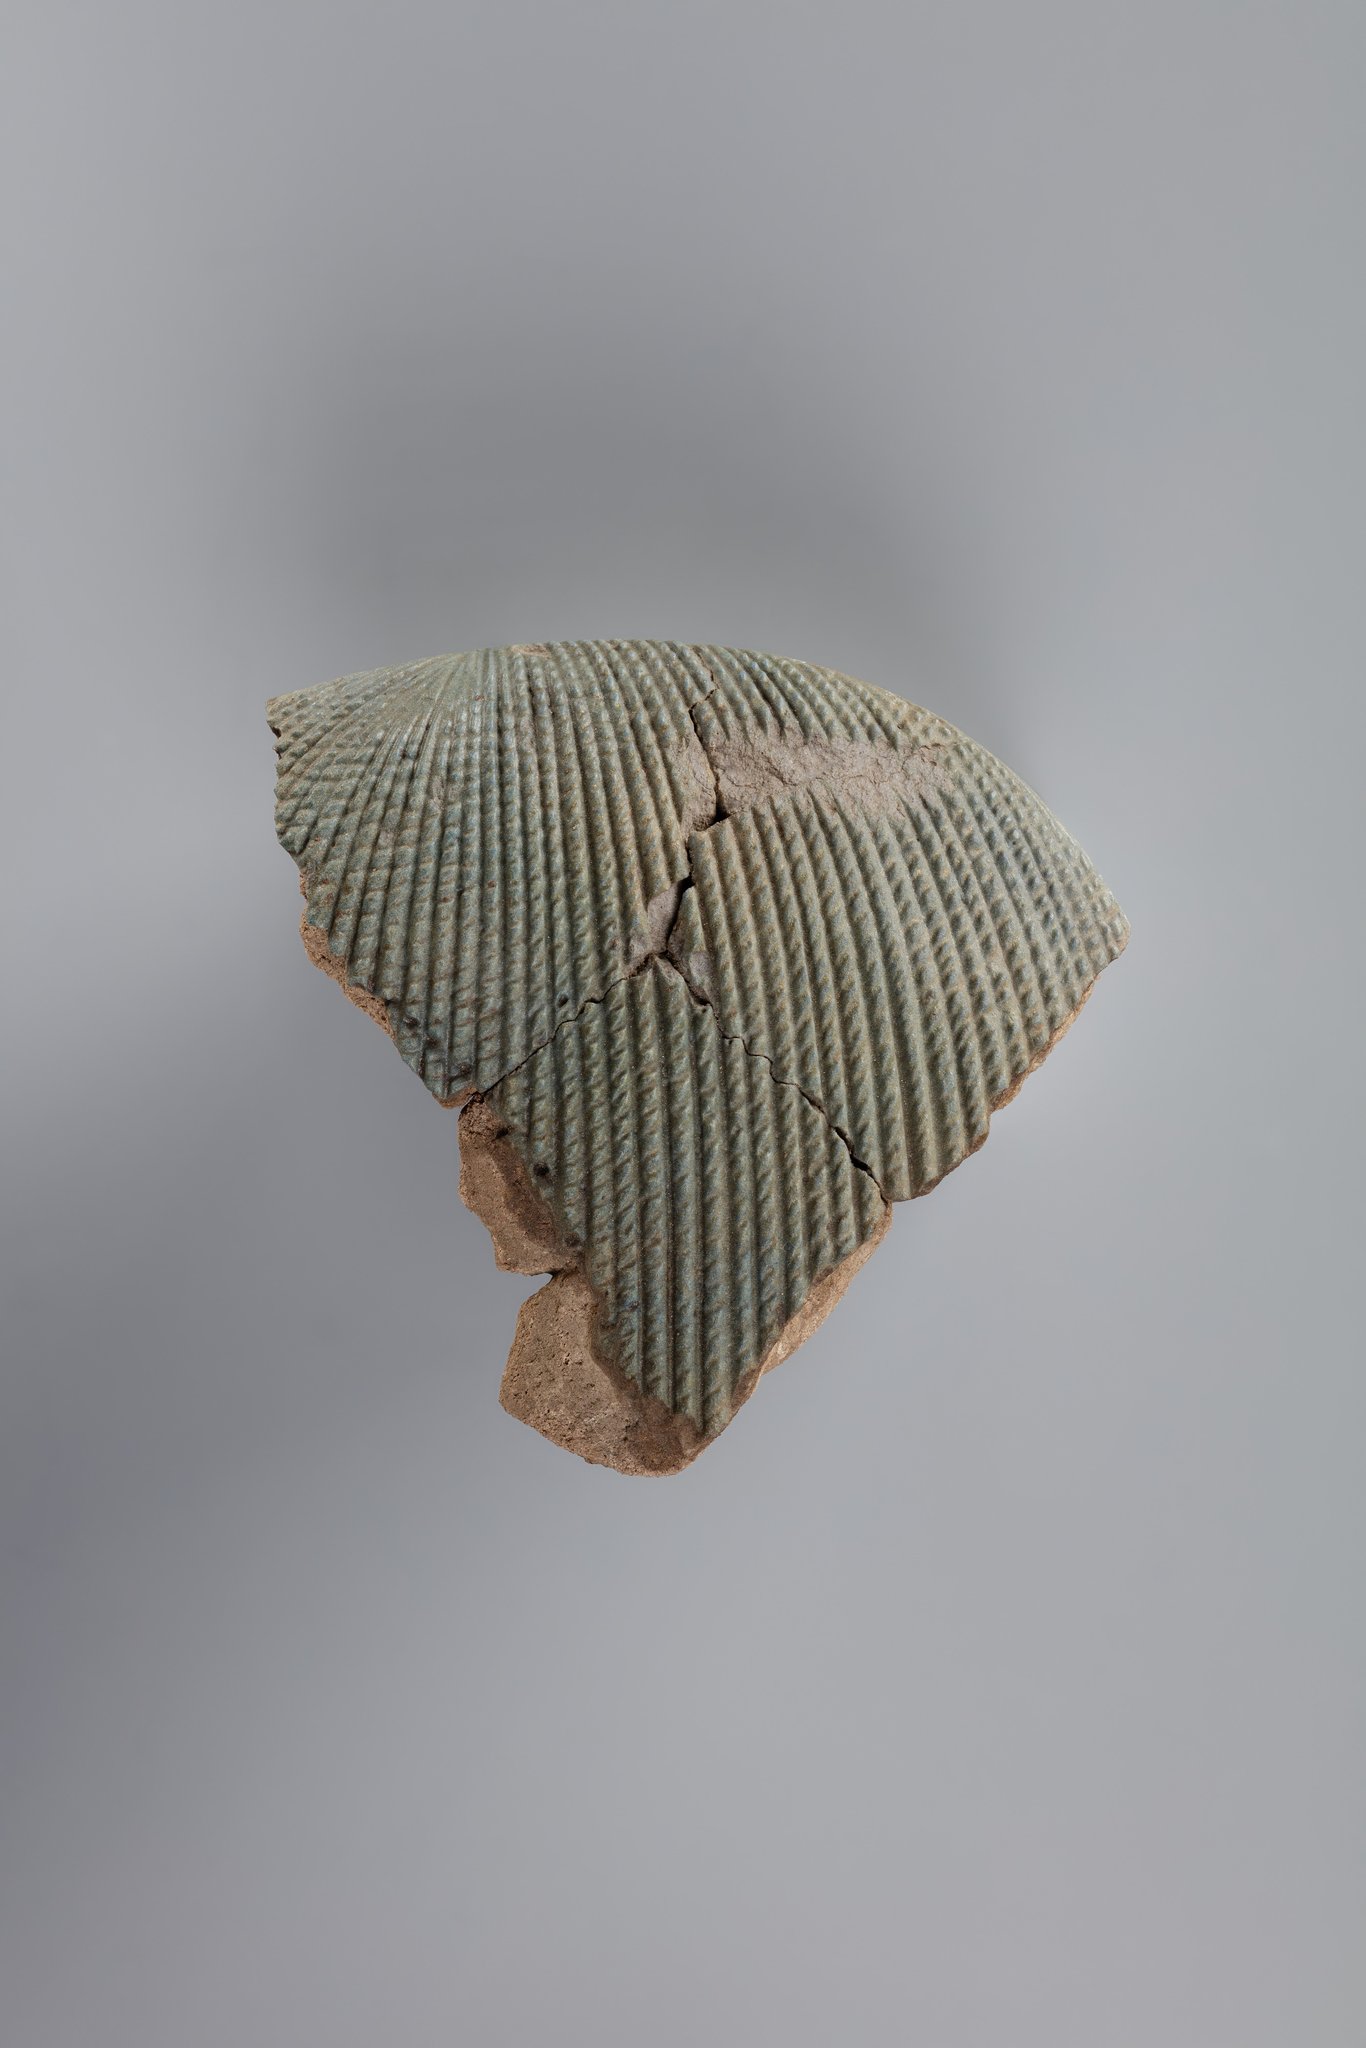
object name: tile, palace of ramesses ii, headdress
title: Tile fragment, part of a wig from a figure of the king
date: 1279-1213 BCE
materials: faience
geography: egypt